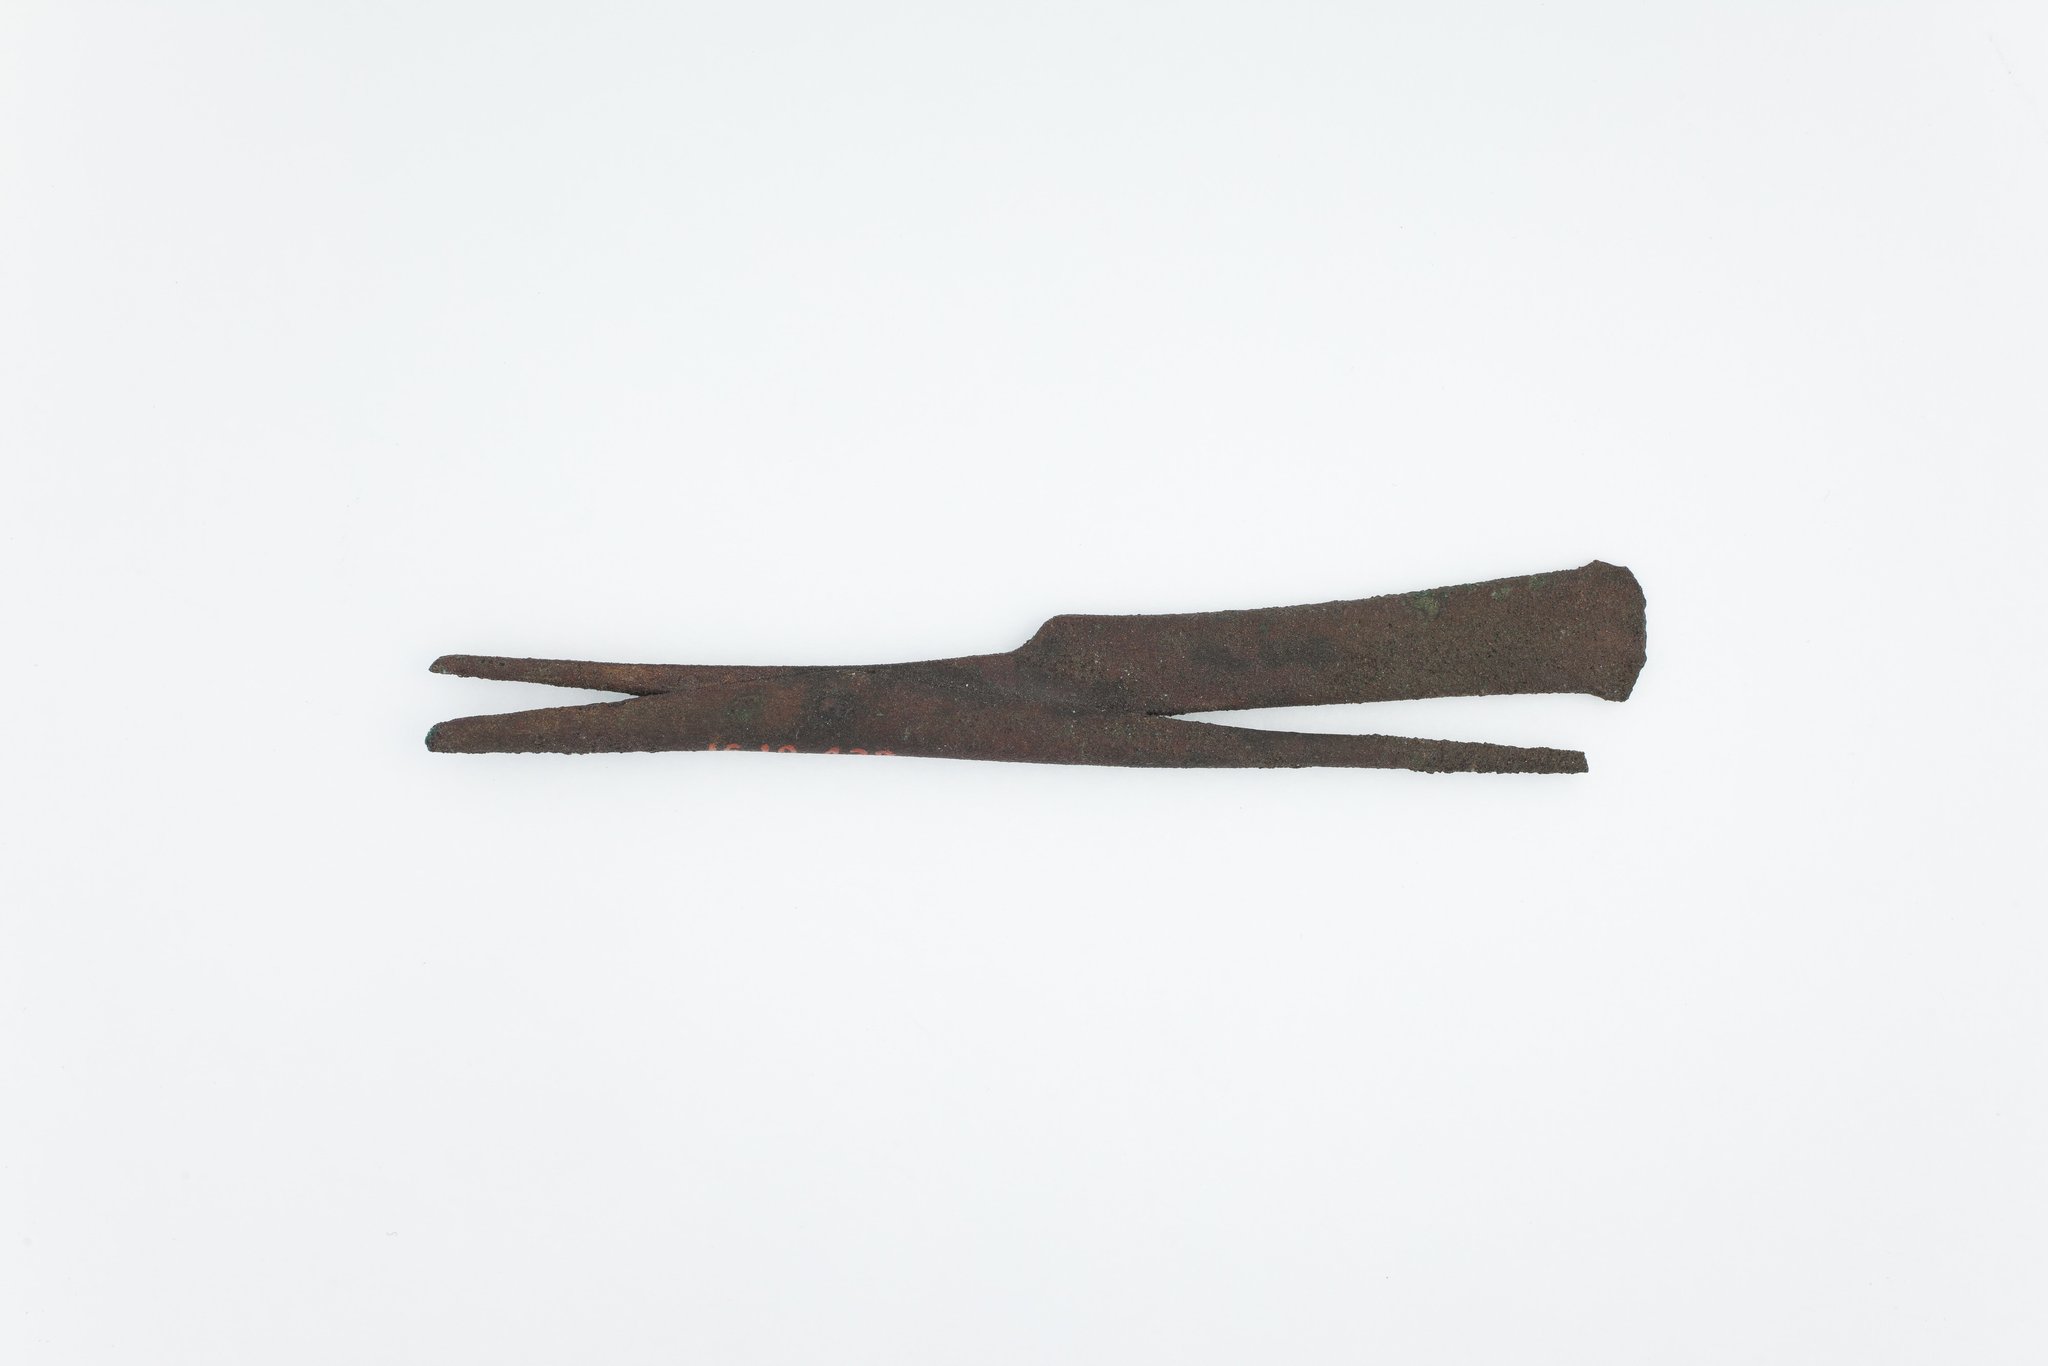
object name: tweezer razor, razor, tweezer, hair curler, knife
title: Tweezer-razor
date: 1550-1458 BCE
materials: copper alloy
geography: egypt